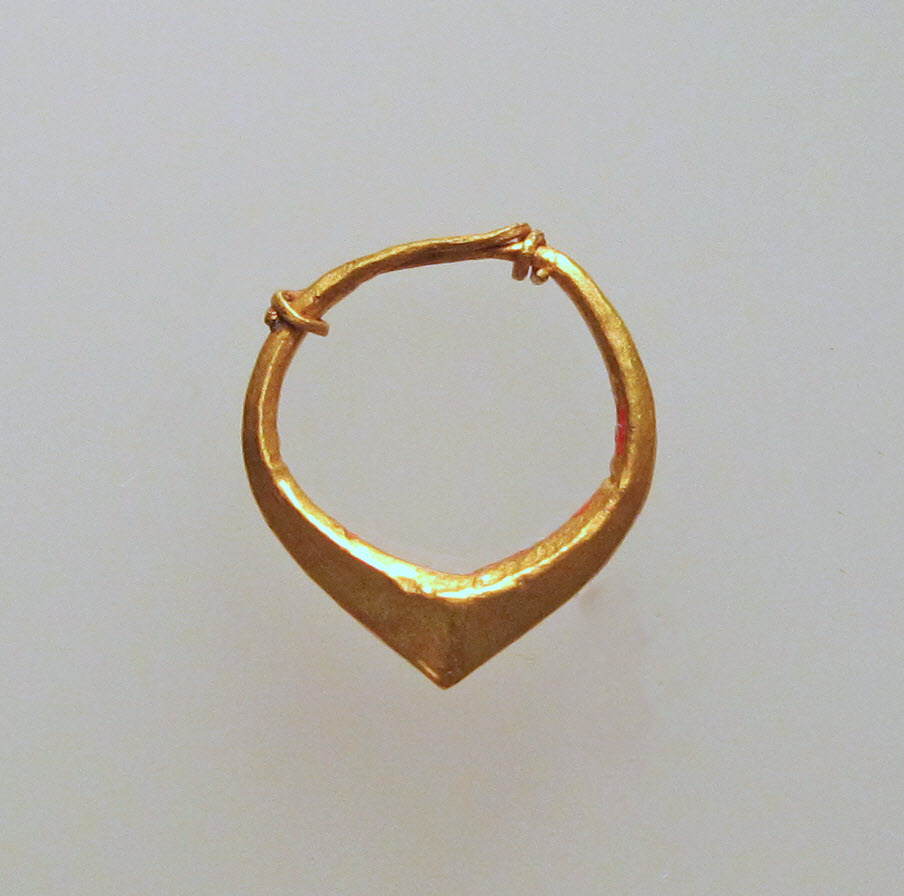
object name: earring of simple form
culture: cypriot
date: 3900 BCE-100 CE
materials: gold